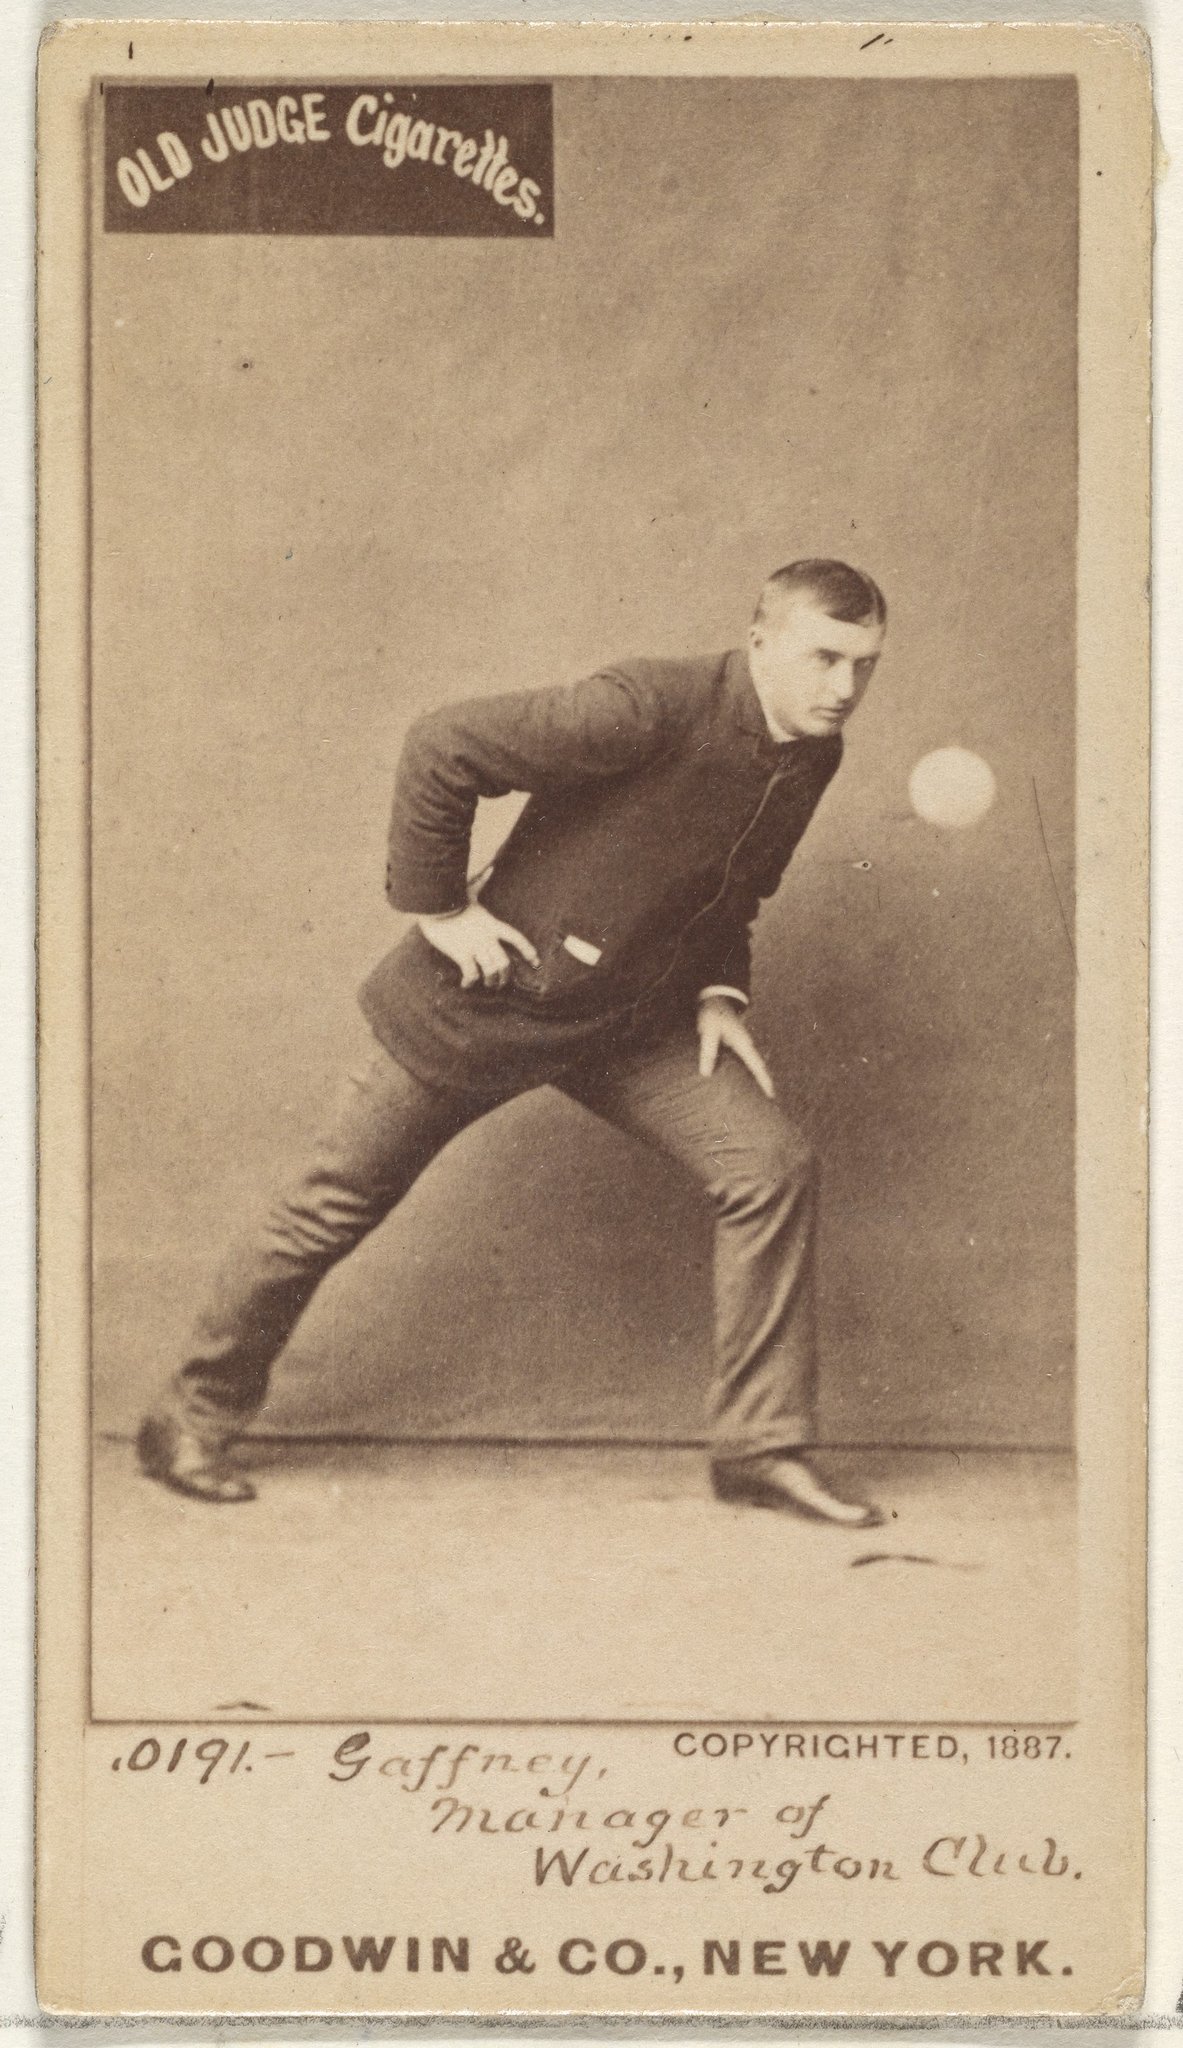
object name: baseball card, photograph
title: John H. "Honest John" Gaffney, Manager, Washington Nationals, from the Old Judge series (N172) for Old Judge Cigarettes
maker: goodwin & company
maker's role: publisher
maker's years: 1850-1950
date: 1887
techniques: albumen silver print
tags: men,portraits,baseball,athletes